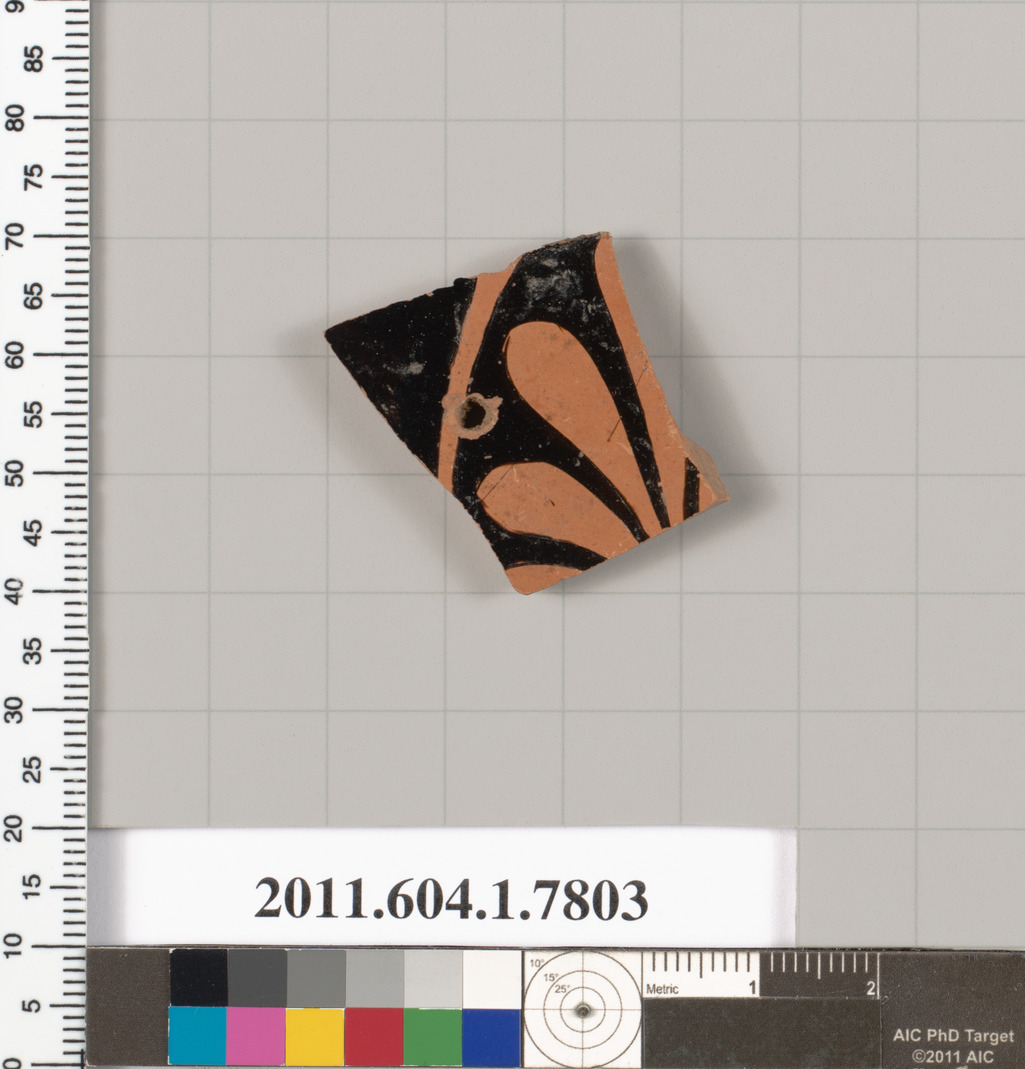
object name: kylix fragment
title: Terracotta fragment of a kylix (drinking cup)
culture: greek, attic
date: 460-450 BCE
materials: terracotta